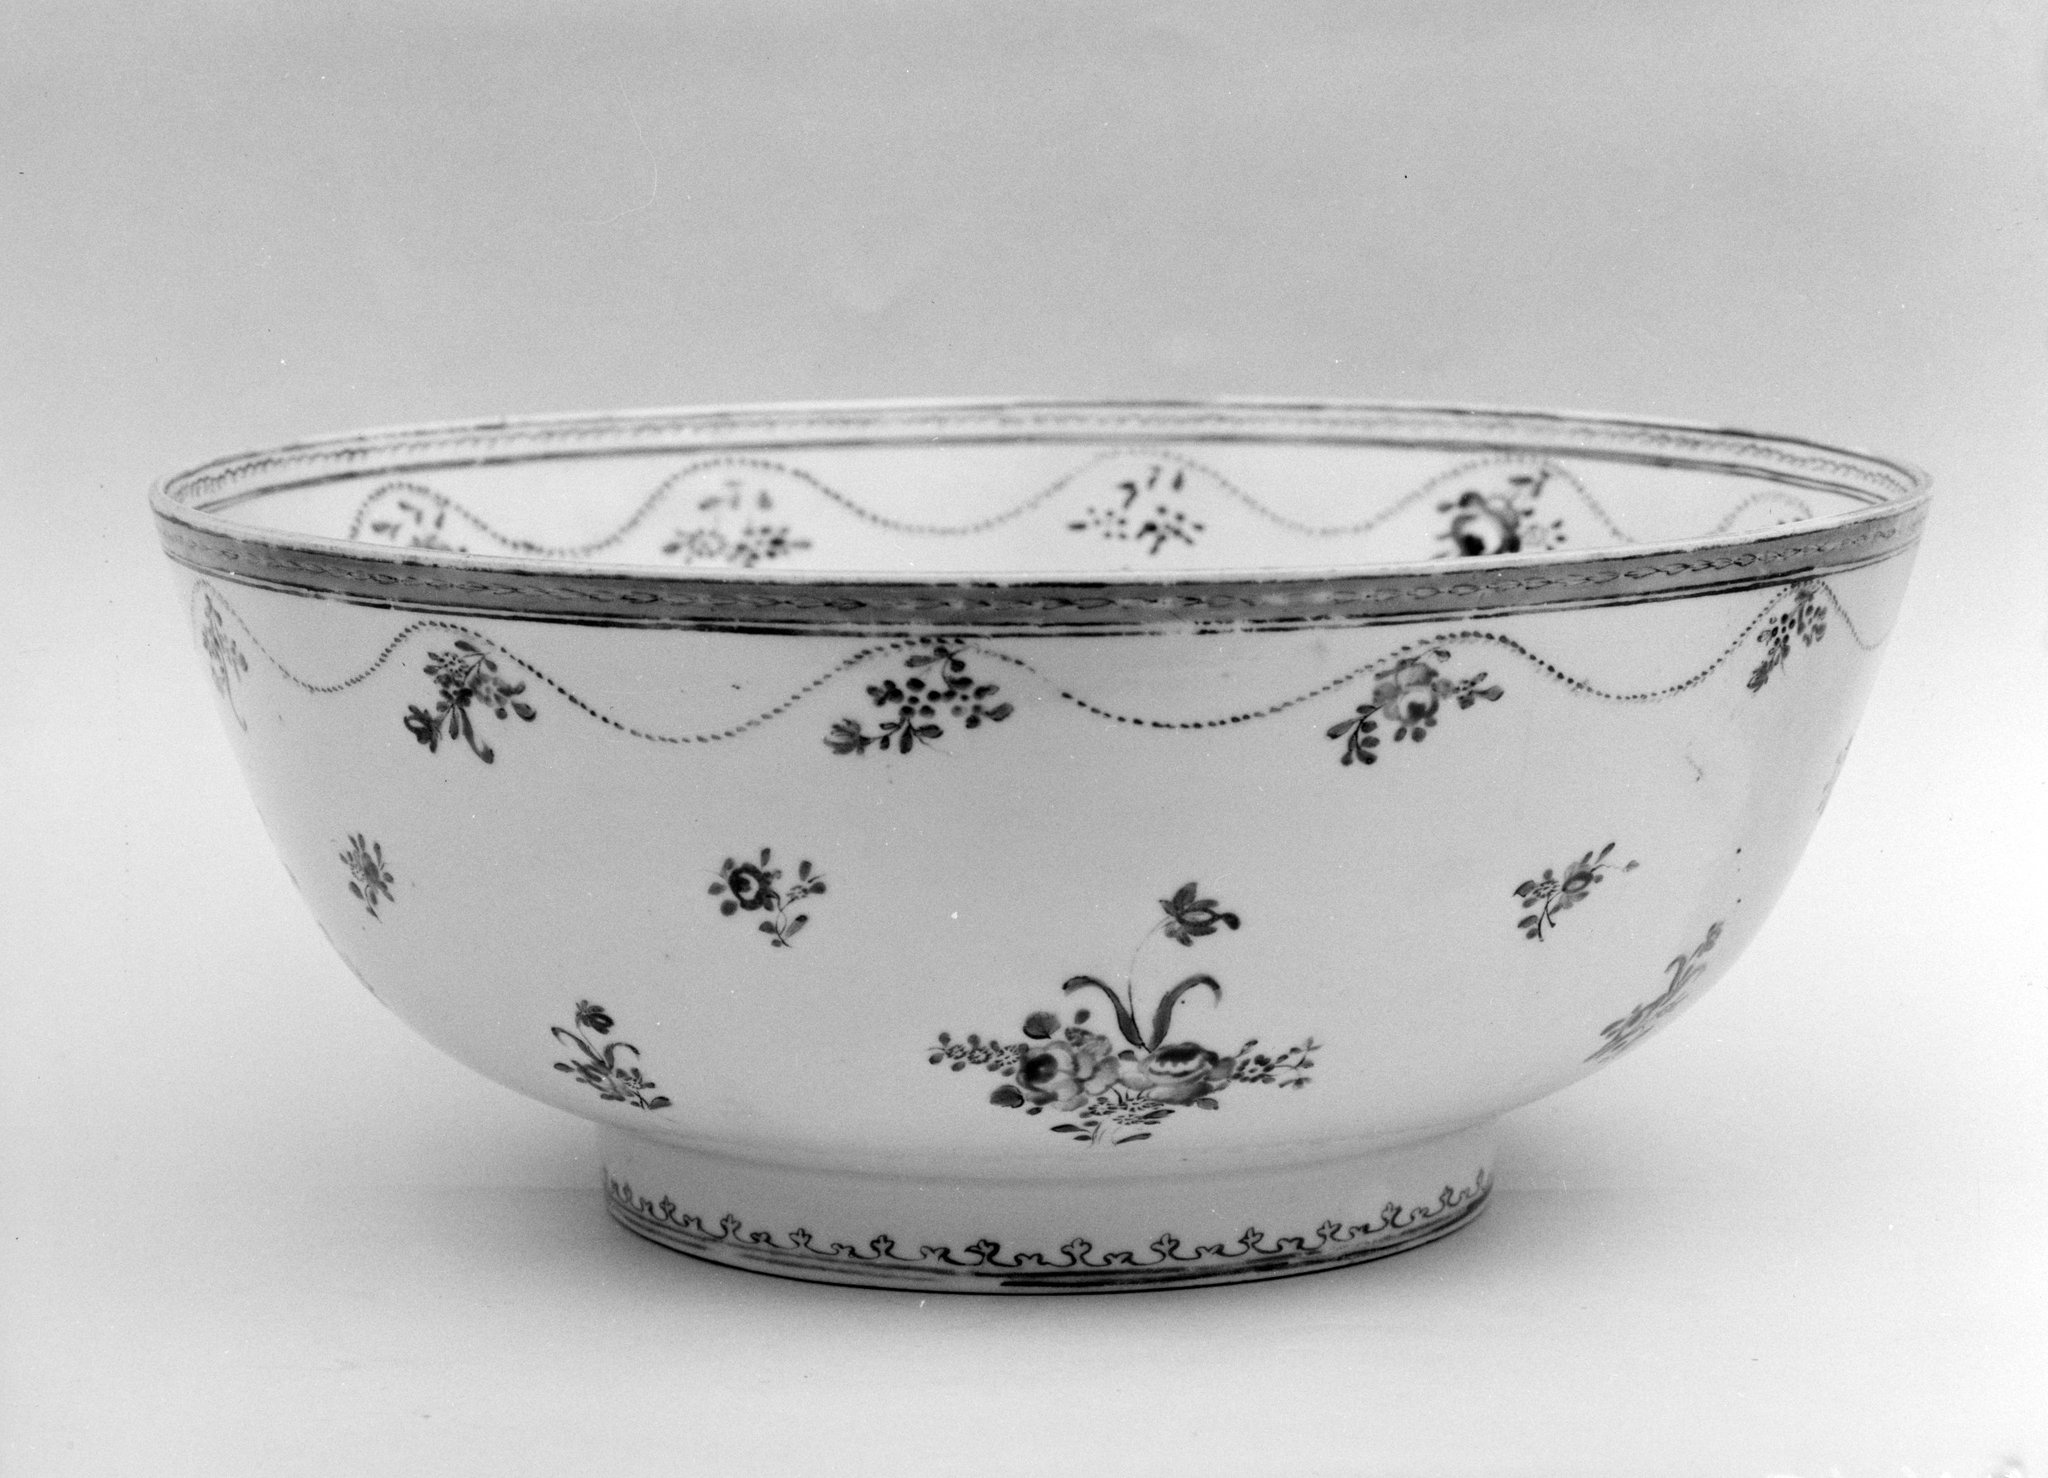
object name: bowl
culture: chinese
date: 1736-1795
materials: porcelain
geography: china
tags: flowers